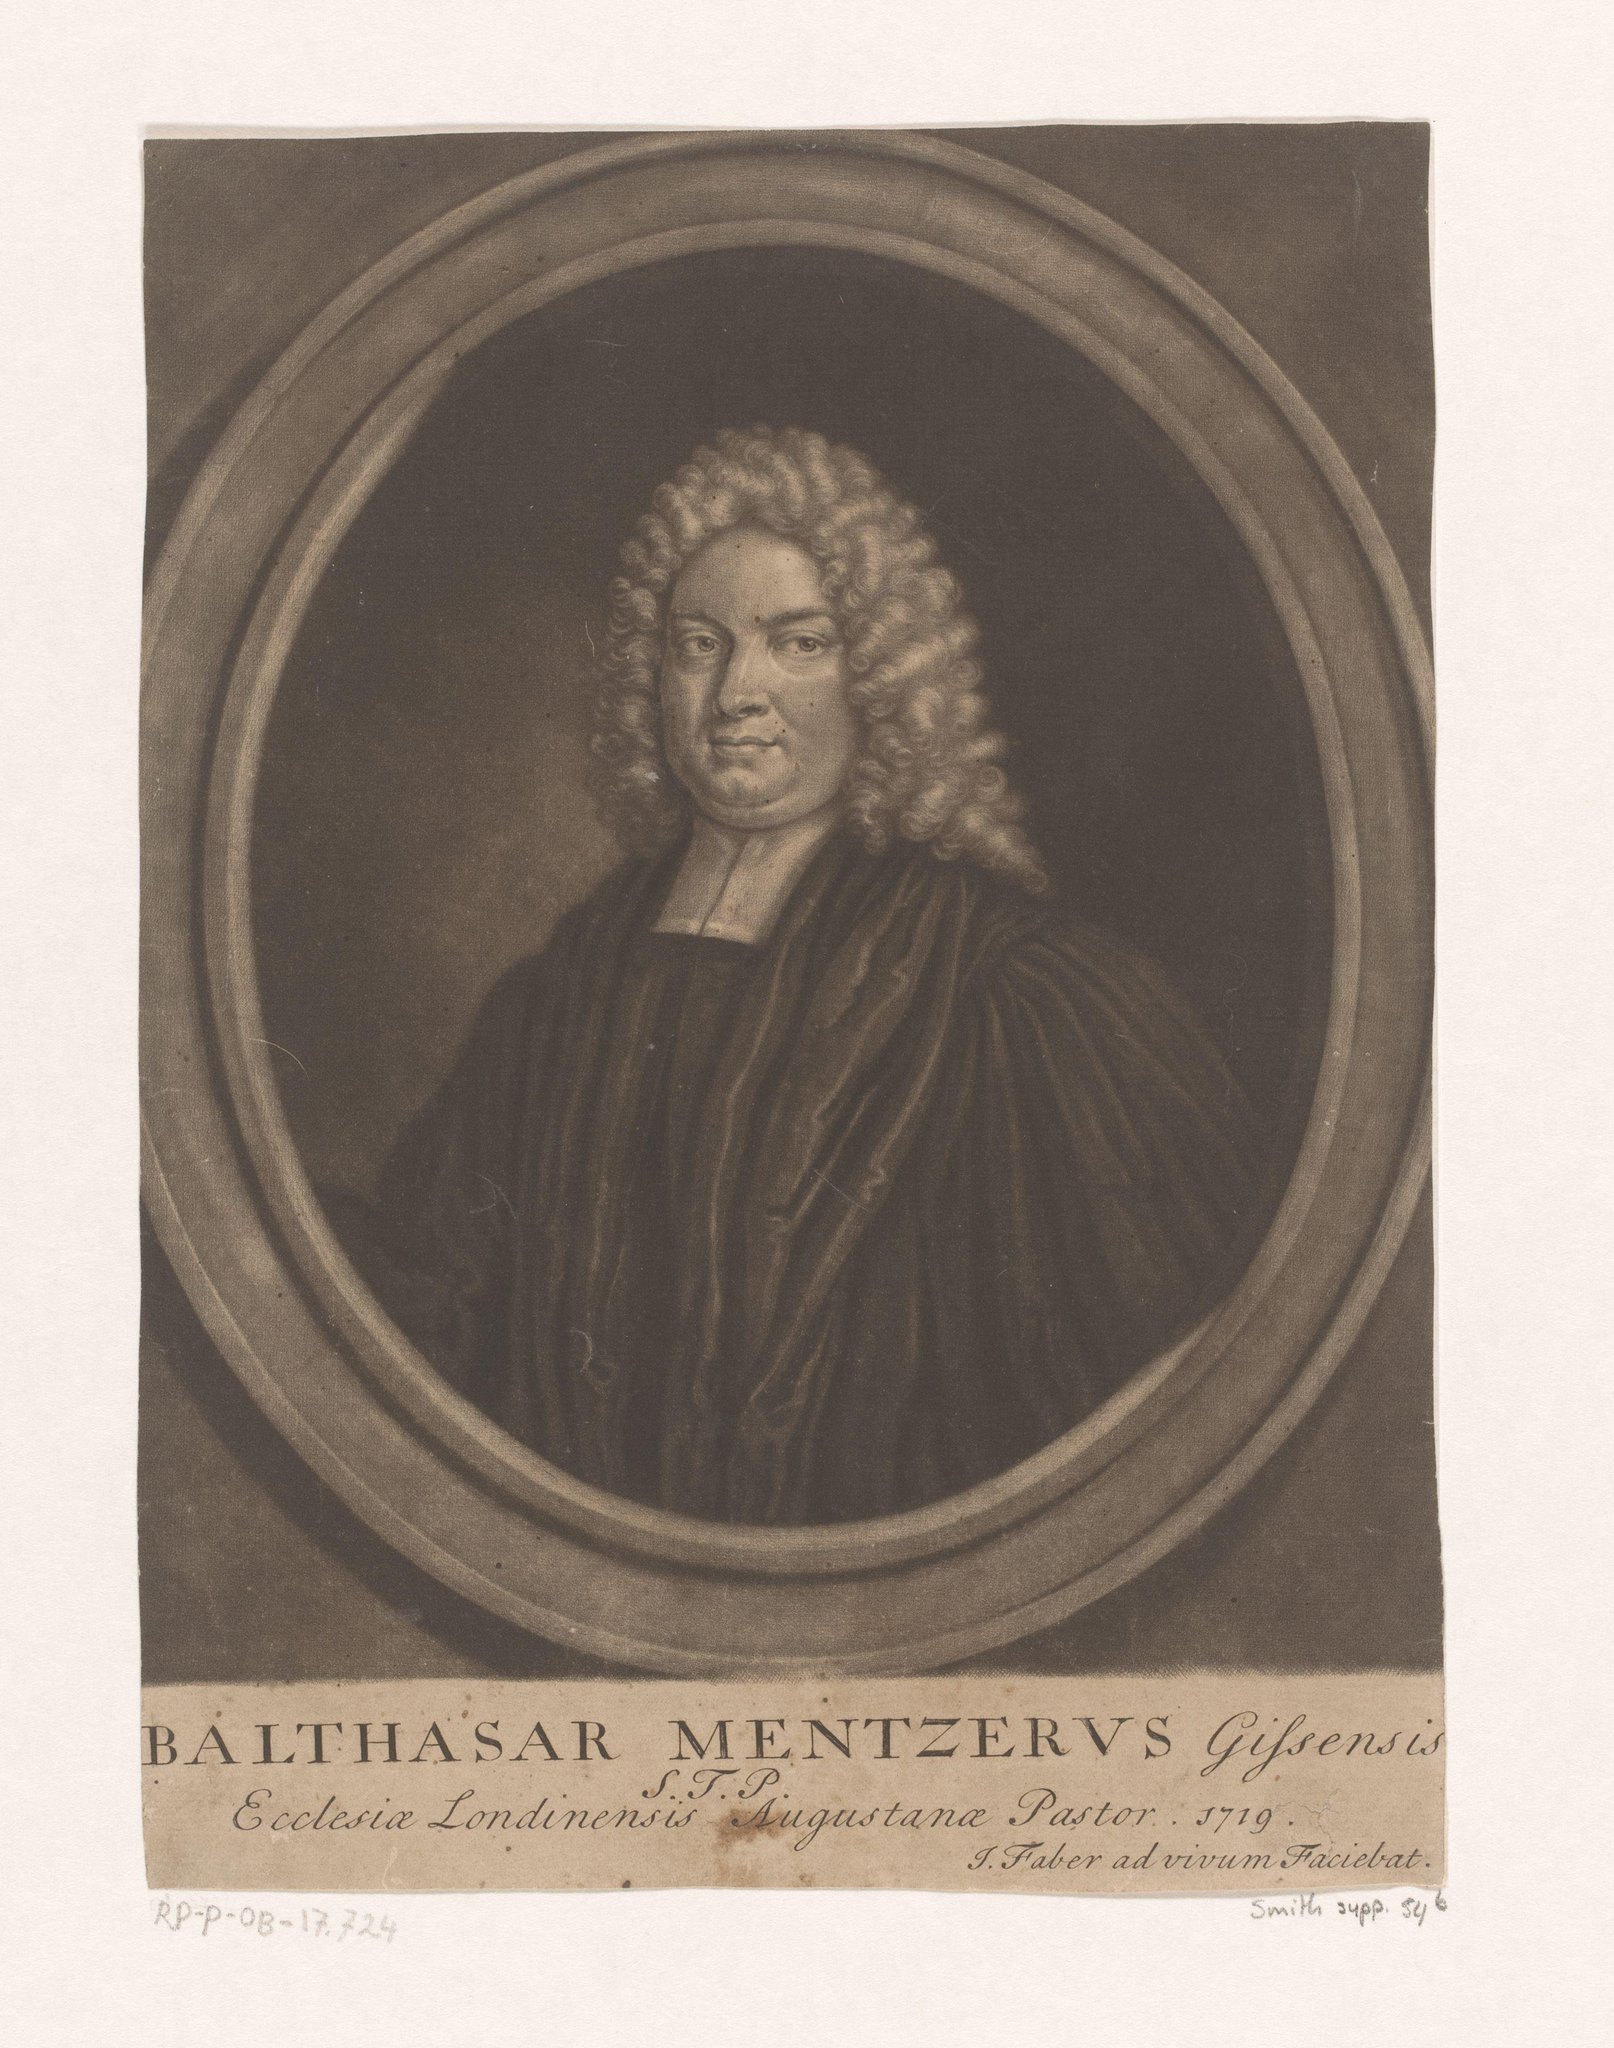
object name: print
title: Portret van Balthasar Mentzer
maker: john faber (i)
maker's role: draughtsman, print maker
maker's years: 1650-1721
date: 1719-1721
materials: paper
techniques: mezzotint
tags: balthasar mentzer, theologian, historical persons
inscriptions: collector's mark: Lugt 2228